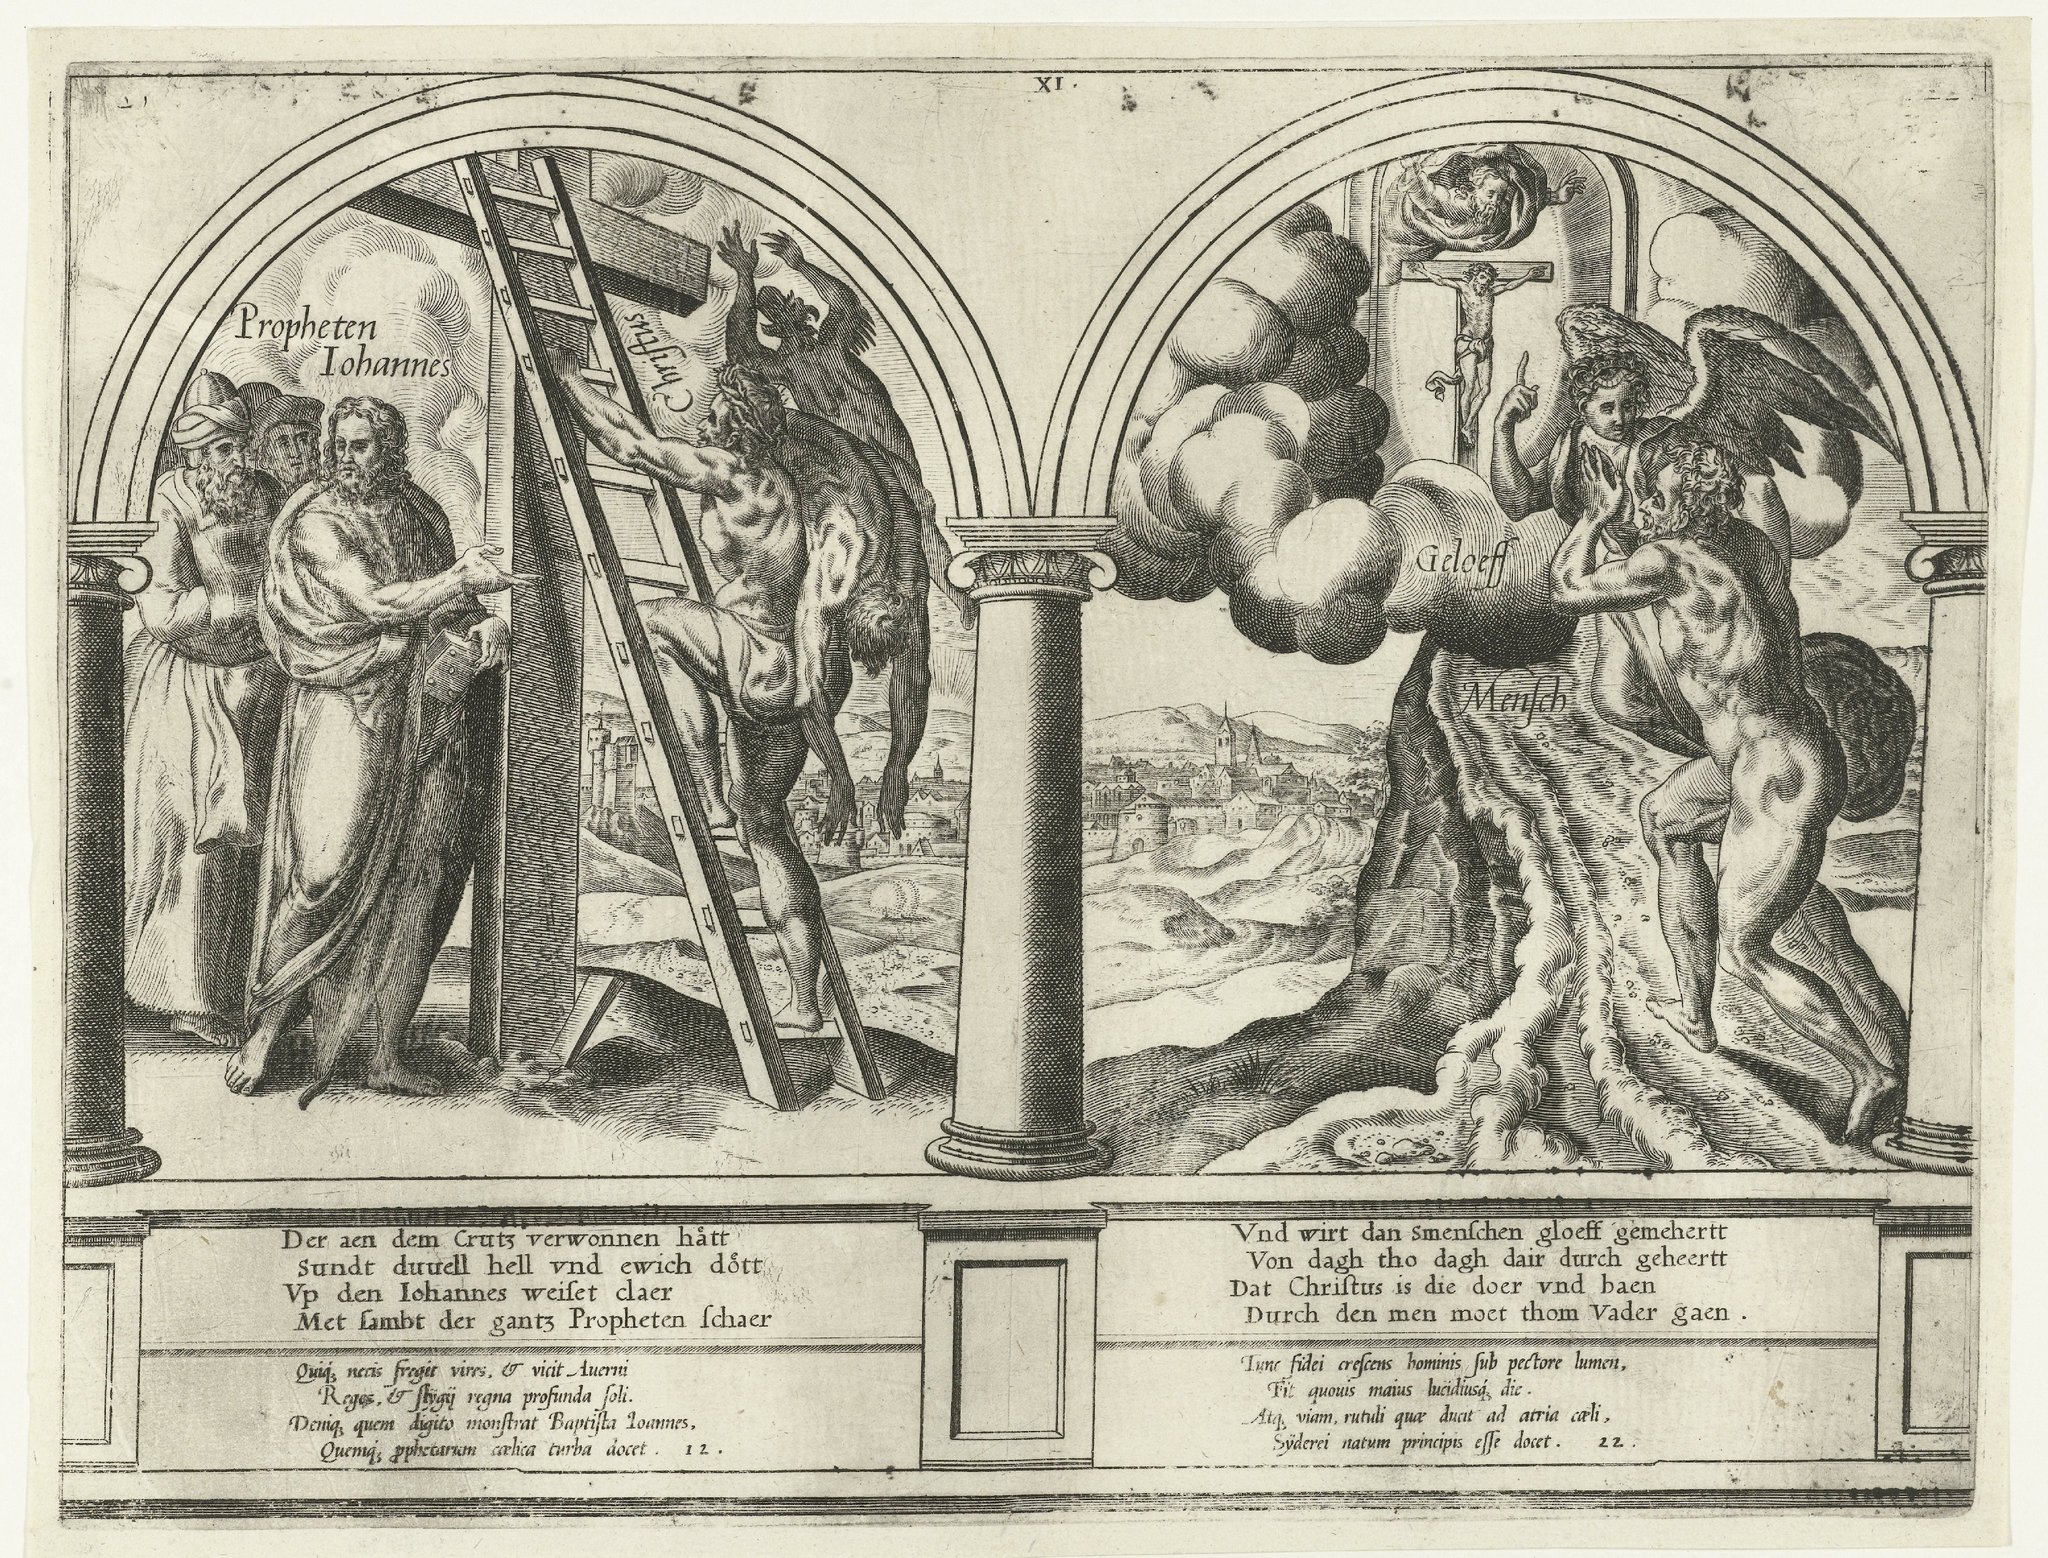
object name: print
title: Overwinning van Christus op de Dood en de Mens door het Geloof de weg gewezen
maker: frans huys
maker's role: print maker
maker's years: 1522-1562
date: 1546-1562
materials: paper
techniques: engraving, etching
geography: antwerp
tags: faith, 'fides'; 'fede', 'fede catholica', 'fede christiana', 'fede christiana catholica' (ripa) ~ one of the three theological virtues, specific types of crucified christ (in non-narrative context), john the baptist identifies christ as the lamb of god ('ecce agnus dei') (john 1:29, 1:36), god the father represented as human being, usually with crown or tiara or sceptre and/or globe, christ mounting the cross (with the help of a ladder) - dd - three crosses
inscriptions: collector's mark: Lugt 2760, collector's mark: Lugt 2228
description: Twee bijbelse allegorieën in architecturale omlijsting. Links beklimt Christus met een ladder het kruis en draagt op zijn rug de Zonde mee, daarachter de Duivel. Naast het kruis staat Johannes de Doper, wijzende op Christus, naast hem enkele profeten. Rechts toont de personificatie van het Geloof de Mens de weg naar God de Vader. Bovenaan de weg de gekruisigde Christus, daarboven God de Vader. Onder beide voorstellingen een vierregelig vers in het Nederduits en een vierregelige tekst in het Latijn. Nummer 21 en 22 uit een reformatorische serie over de zondigheid en rechtvaardiging van de mens.